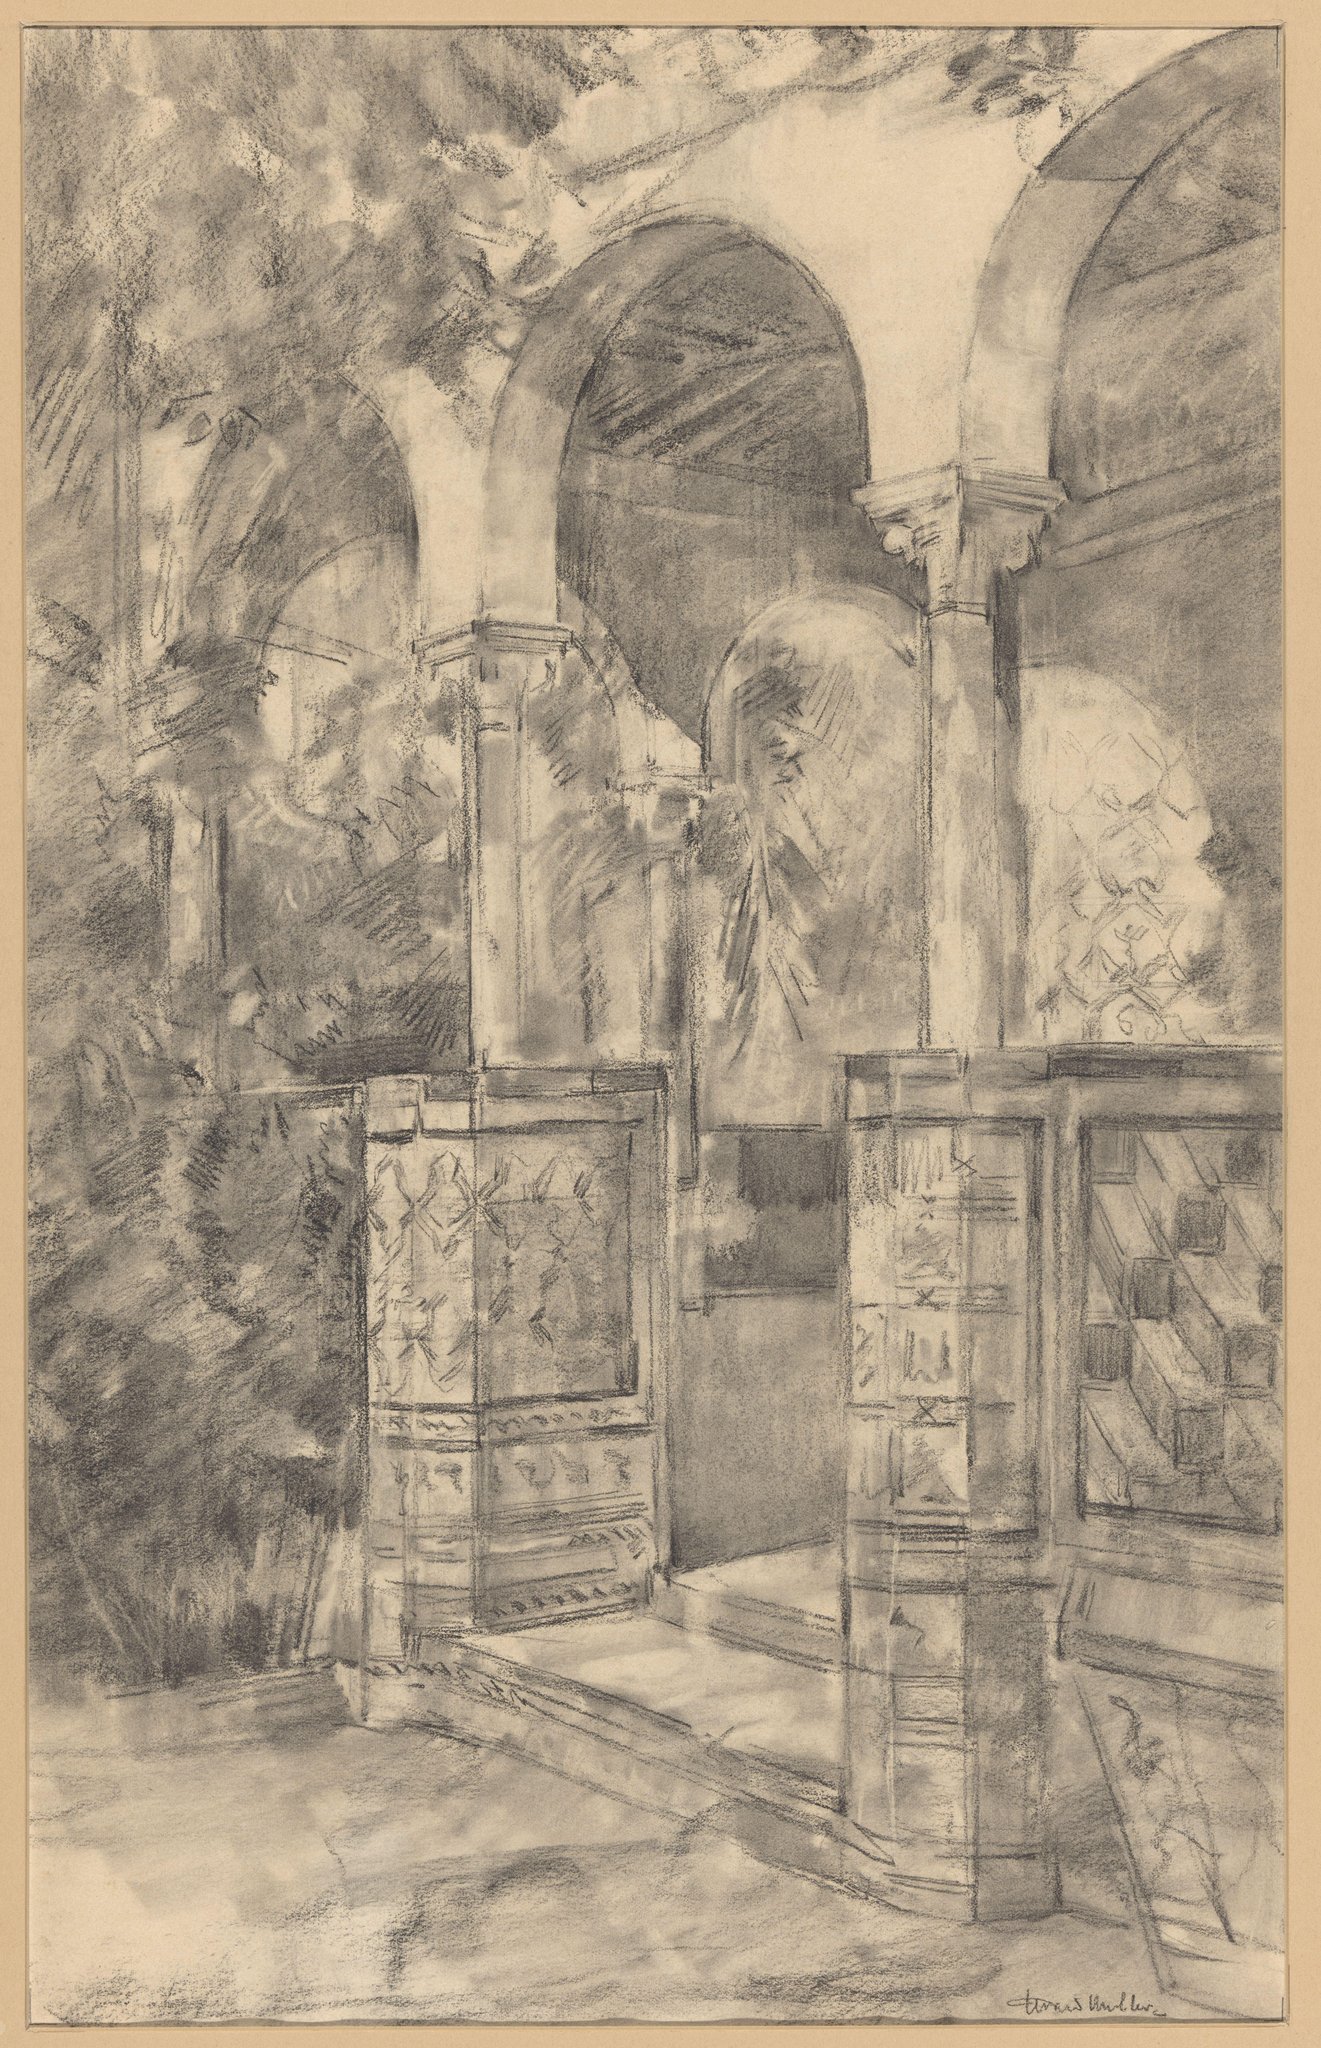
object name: drawing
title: Paviljoen van Karel V in het Koninklijk Paleis te Sevilla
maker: gerard muller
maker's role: draughtsman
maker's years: 1861-1929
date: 1871-1903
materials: chalk, paper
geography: sevilla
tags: palace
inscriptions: collector's mark: Lugt 2228, label: ‘22. Alcázar . Sevilla/ Pavilloen Karel V.’